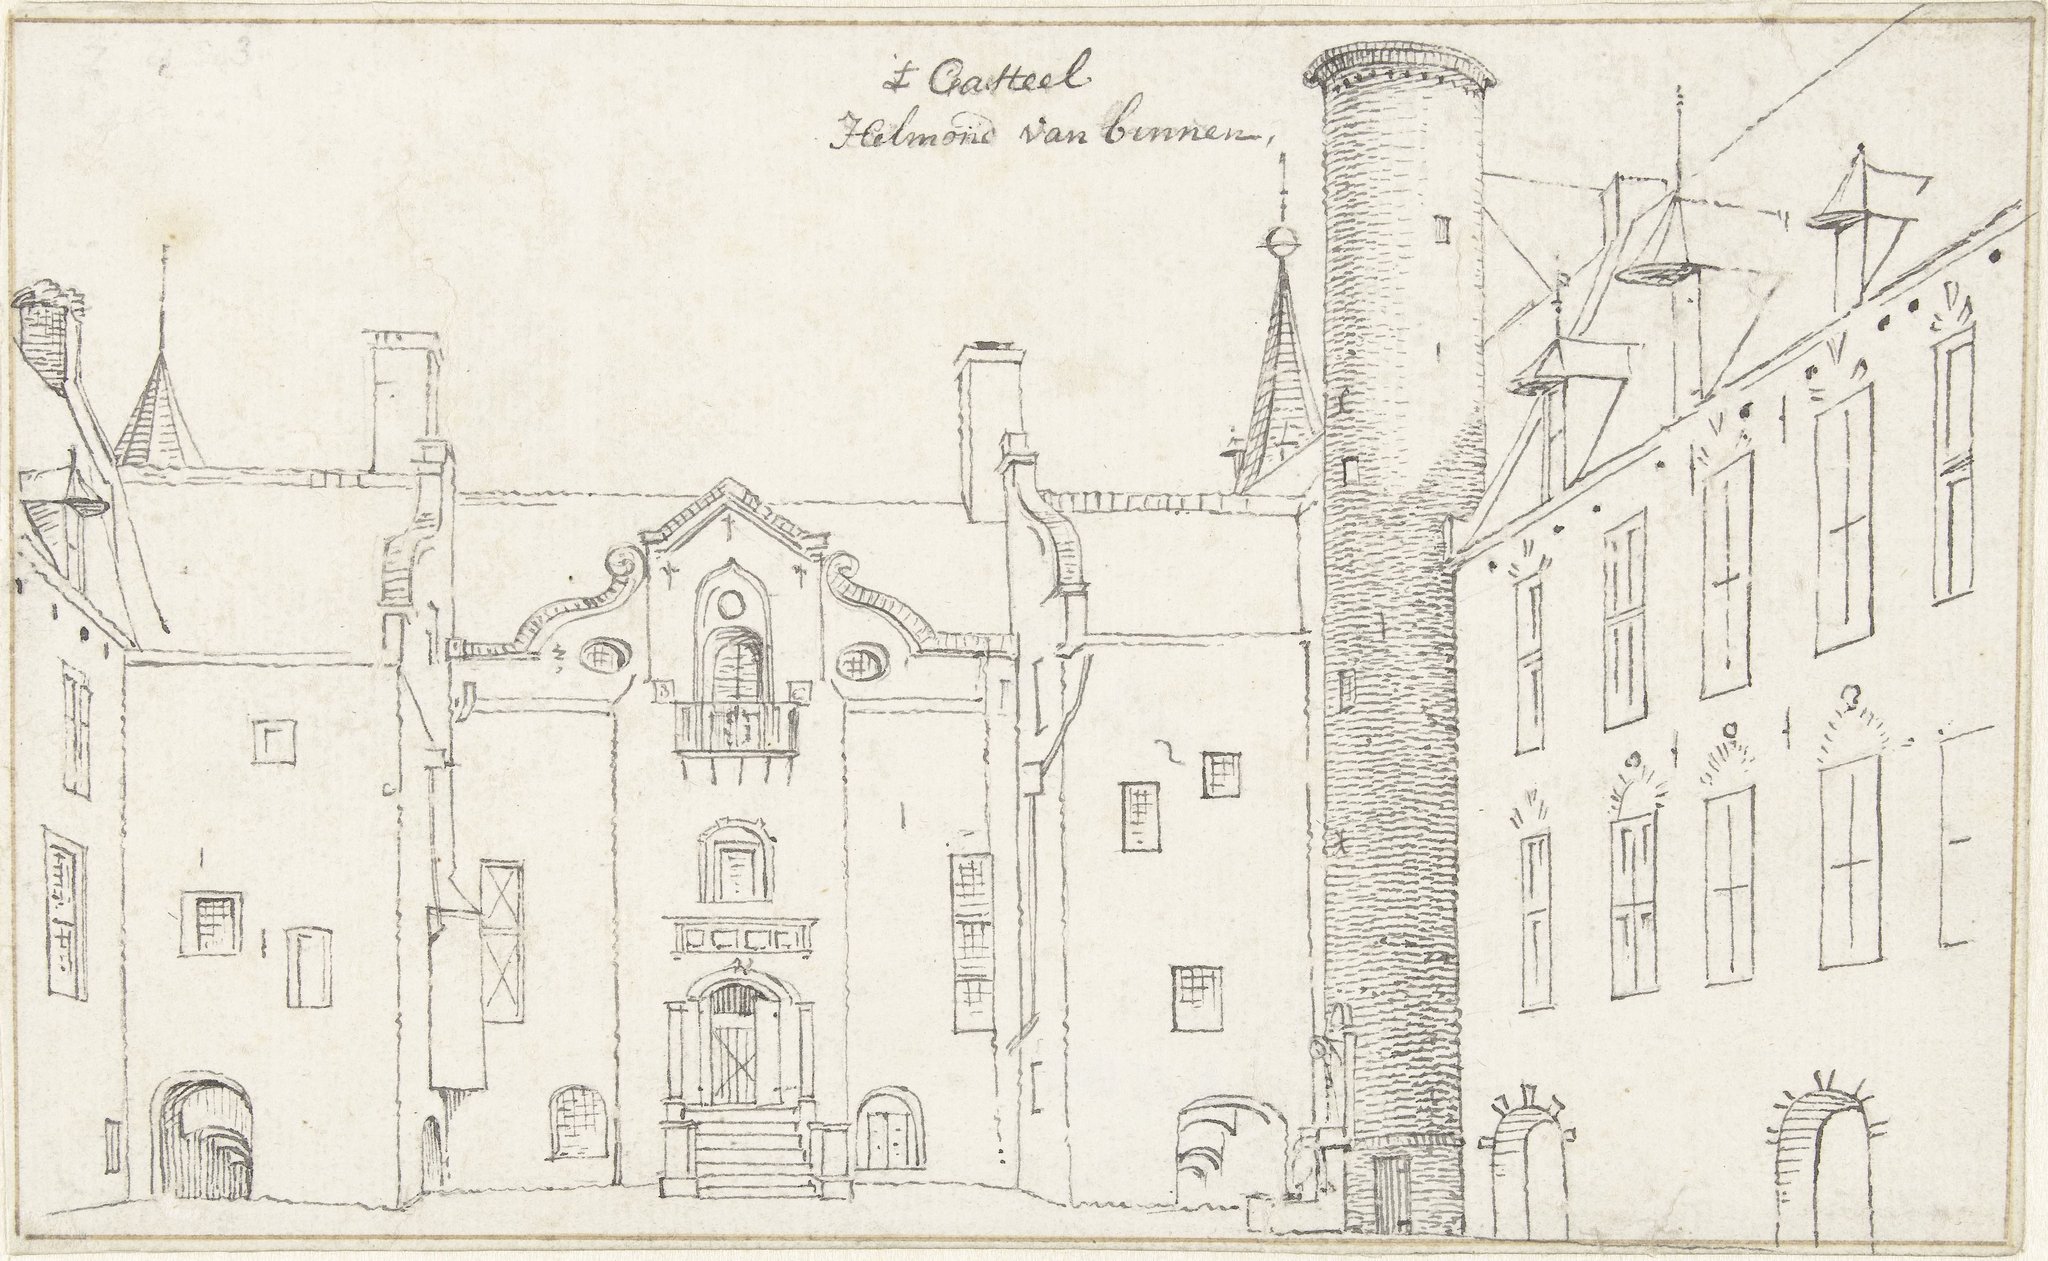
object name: drawing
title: Binnenplaats van het kasteel te Helmond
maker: cornelis pronk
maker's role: draughtsman, painter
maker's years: 1691-1759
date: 1720-1740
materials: ink, paper, pencil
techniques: pen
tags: castle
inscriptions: inscription: ‘'t Casteel / Helmond van binnen’